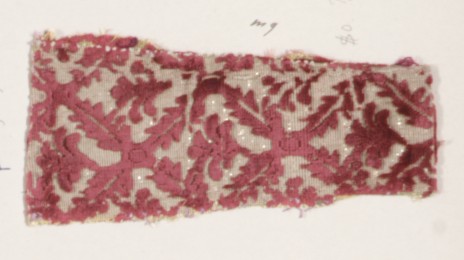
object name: fragment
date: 1701-1800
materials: metal thread, silk